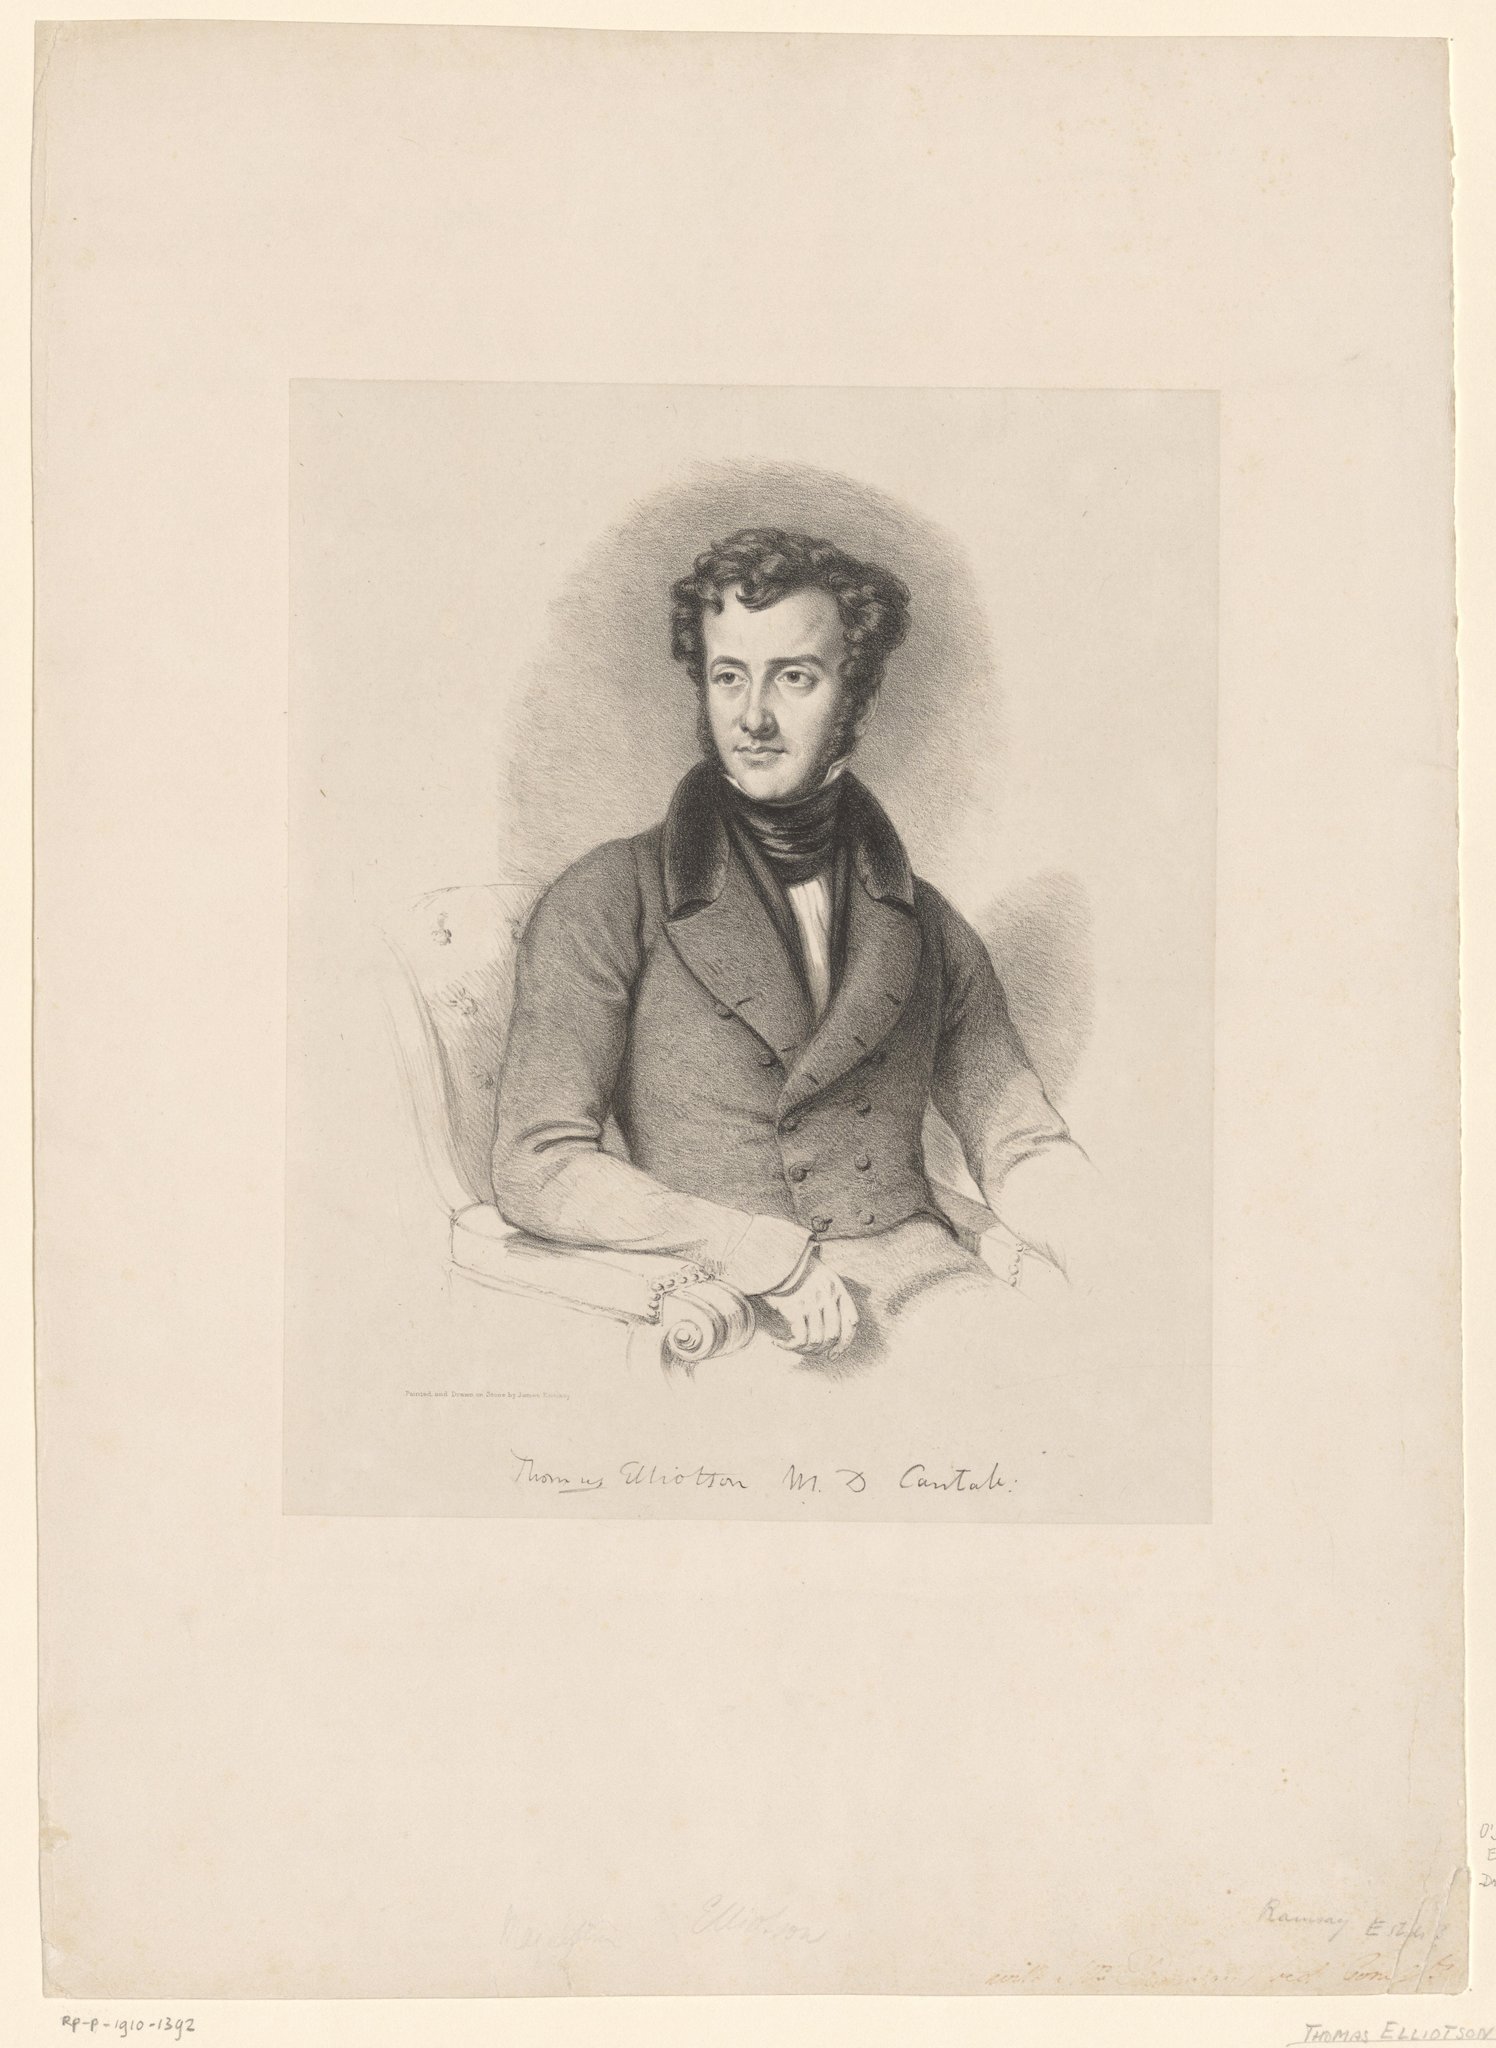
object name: print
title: Portret van Thomas Elliotson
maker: james ramsay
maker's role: print maker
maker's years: 1786-1854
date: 1837-1854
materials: paper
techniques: lithograph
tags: historical persons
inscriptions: collector's mark: Lugt 2228, inscription: ‘with Mr. Ramsays best Compl[imen]ts’